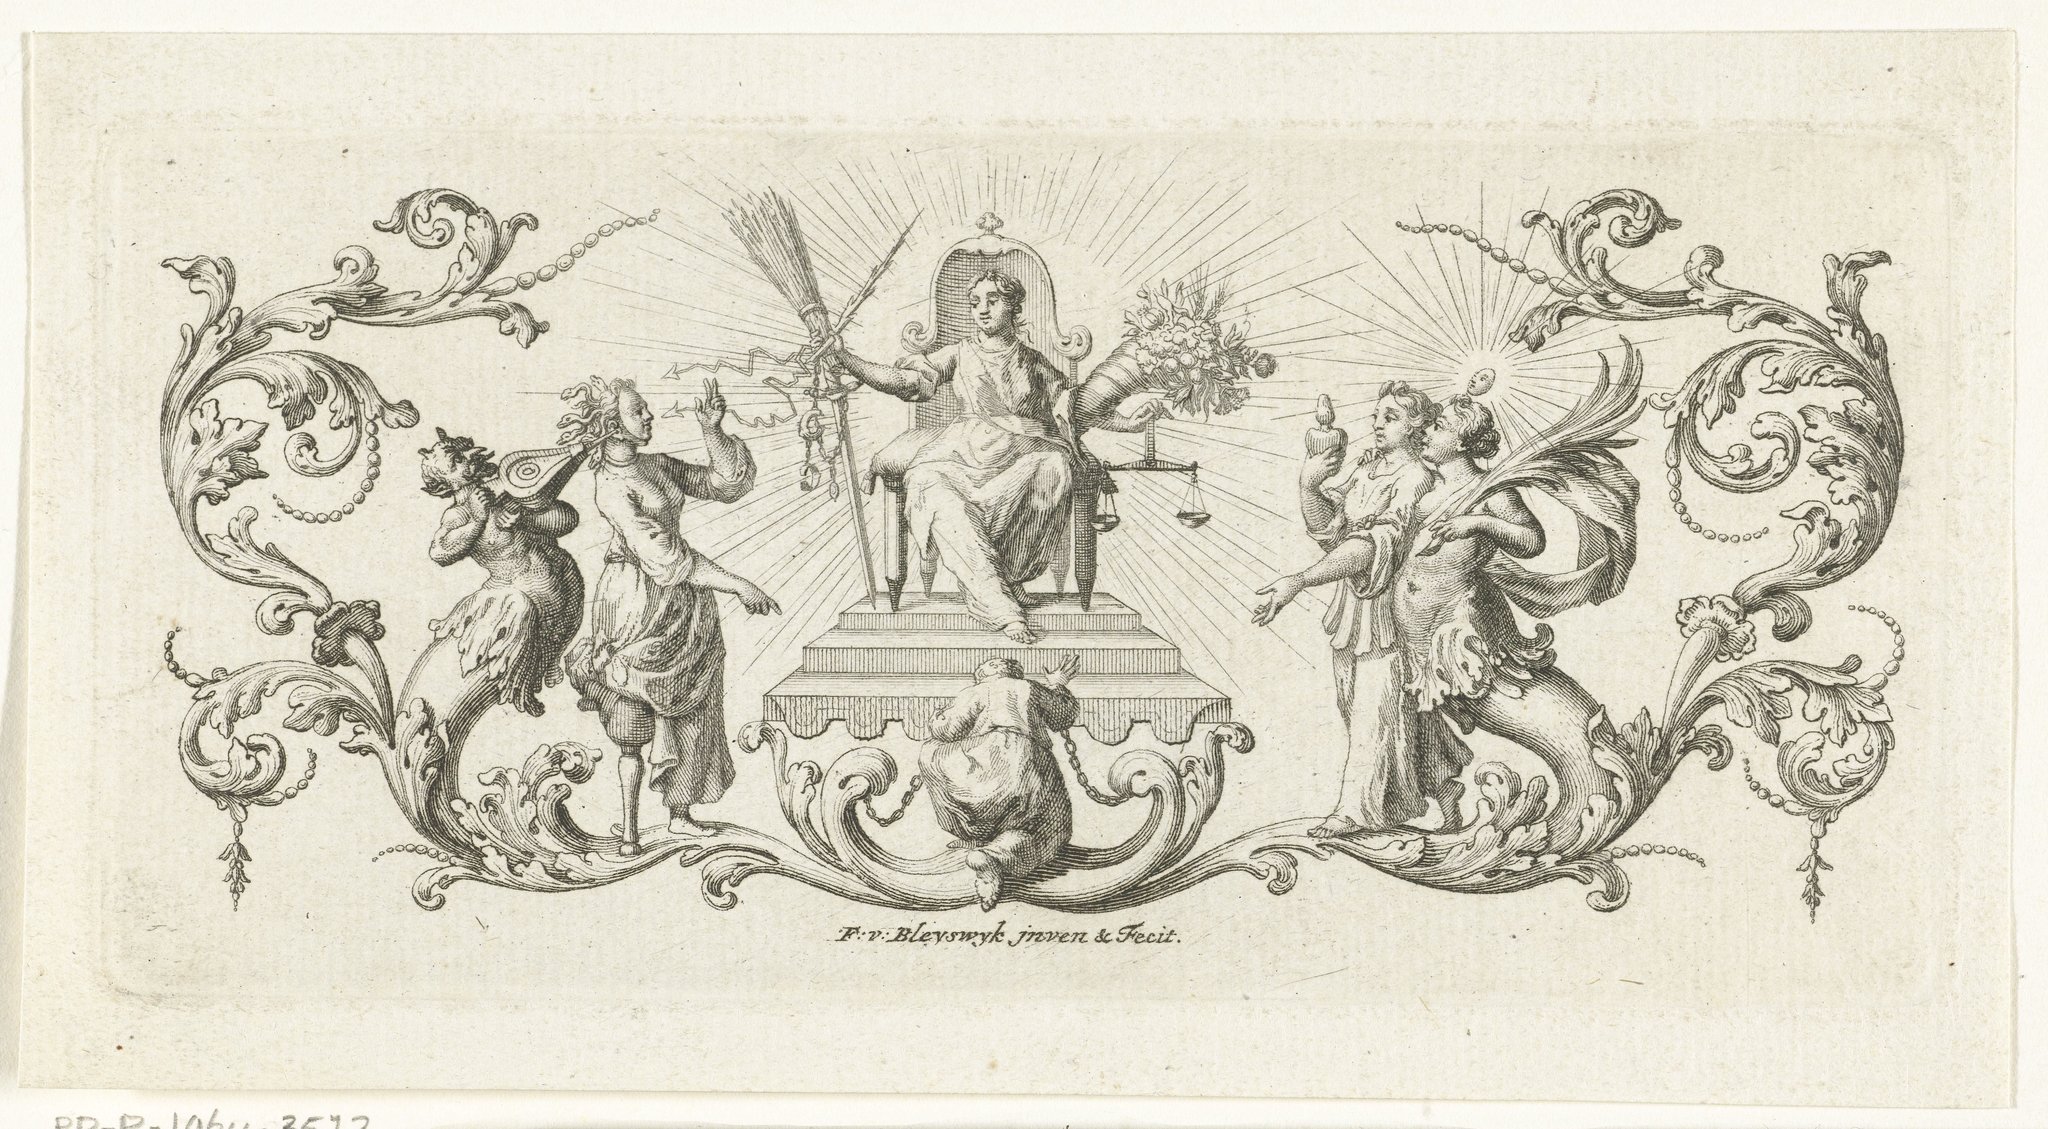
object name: print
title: Allegorie op de gerechtigheid met deugden en ondeugden en bladornamenten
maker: françois van bleyswijck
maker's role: draughtsman, print maker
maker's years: 1671-1746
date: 1681-1746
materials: paper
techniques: etching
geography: leiden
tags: justice; 'forza alla giustitia sottoposta', 'giustitia', 'giustitia retta', 'giustitia rigorosa', 'impietà e violenza soggetta alla giustitia' (ripa)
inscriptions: collector's mark: Lugt 2228